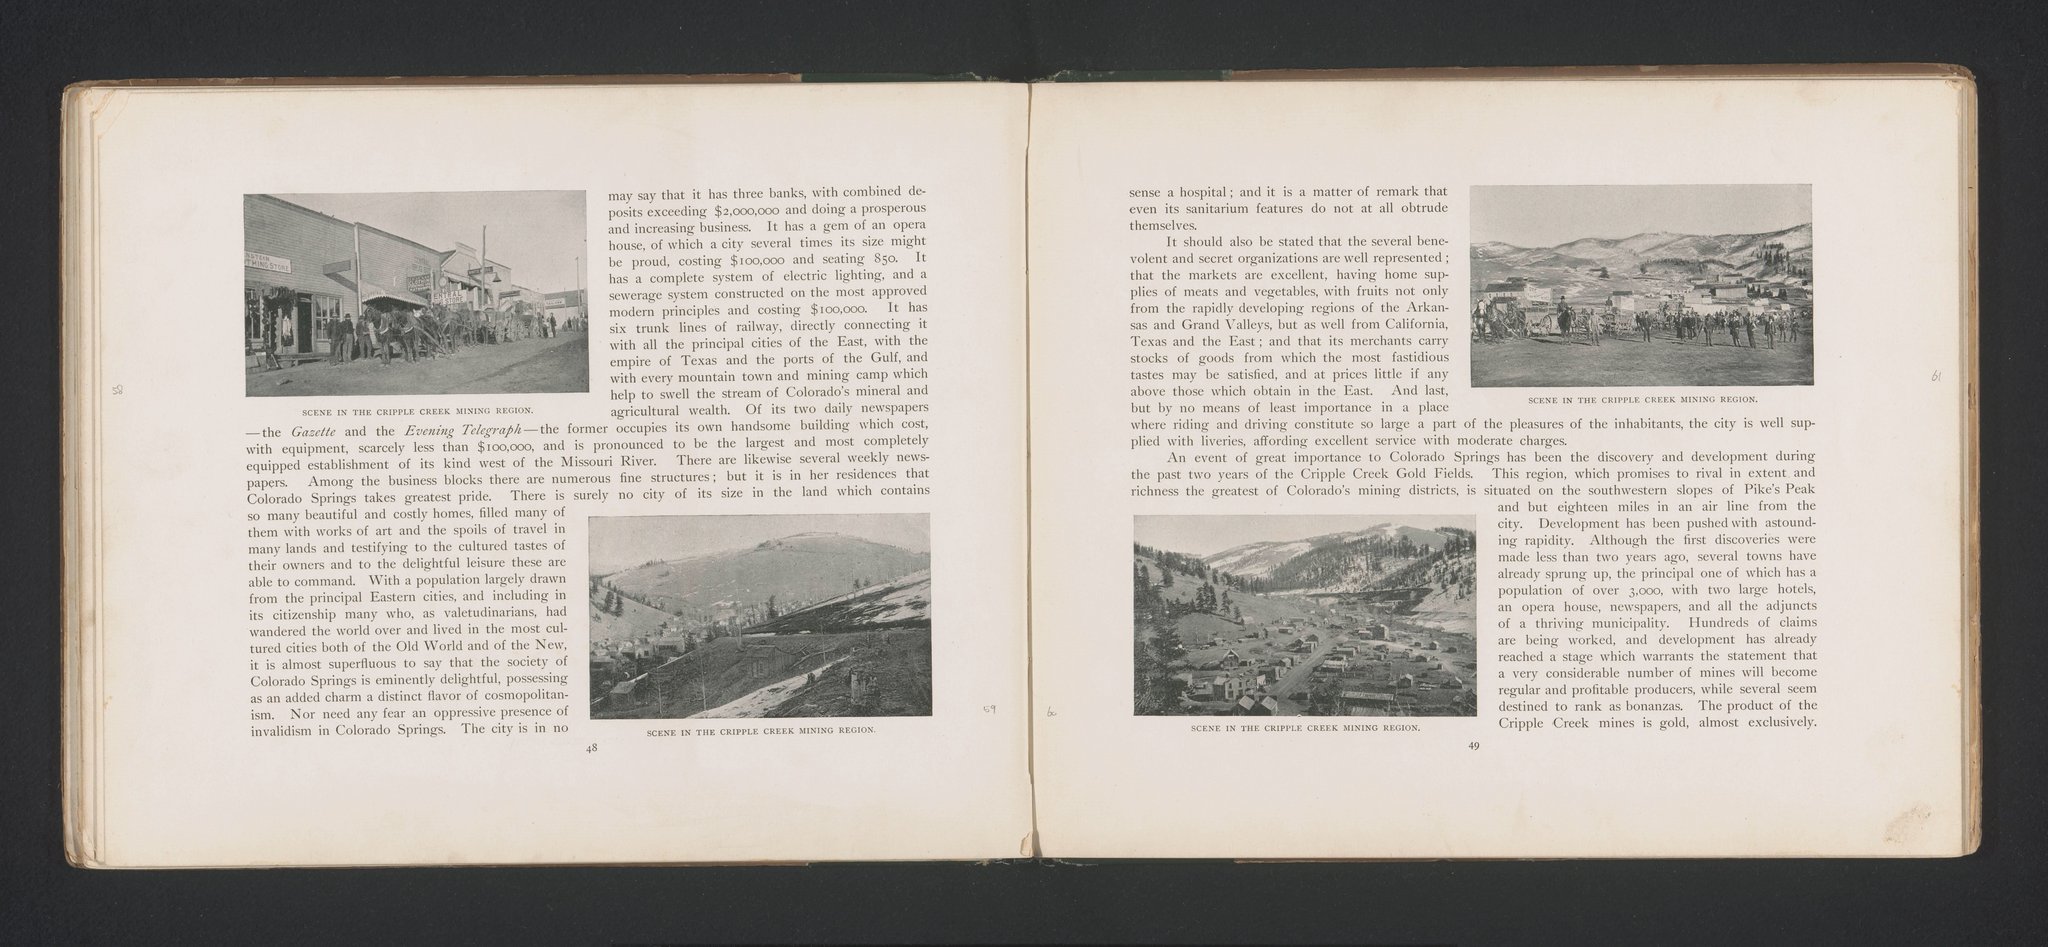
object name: page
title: Scene in the Cripple Creek mining region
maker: Anonymous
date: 1888-1893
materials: paper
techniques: autotype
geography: cripple creek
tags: city-view in general; 'veduta'